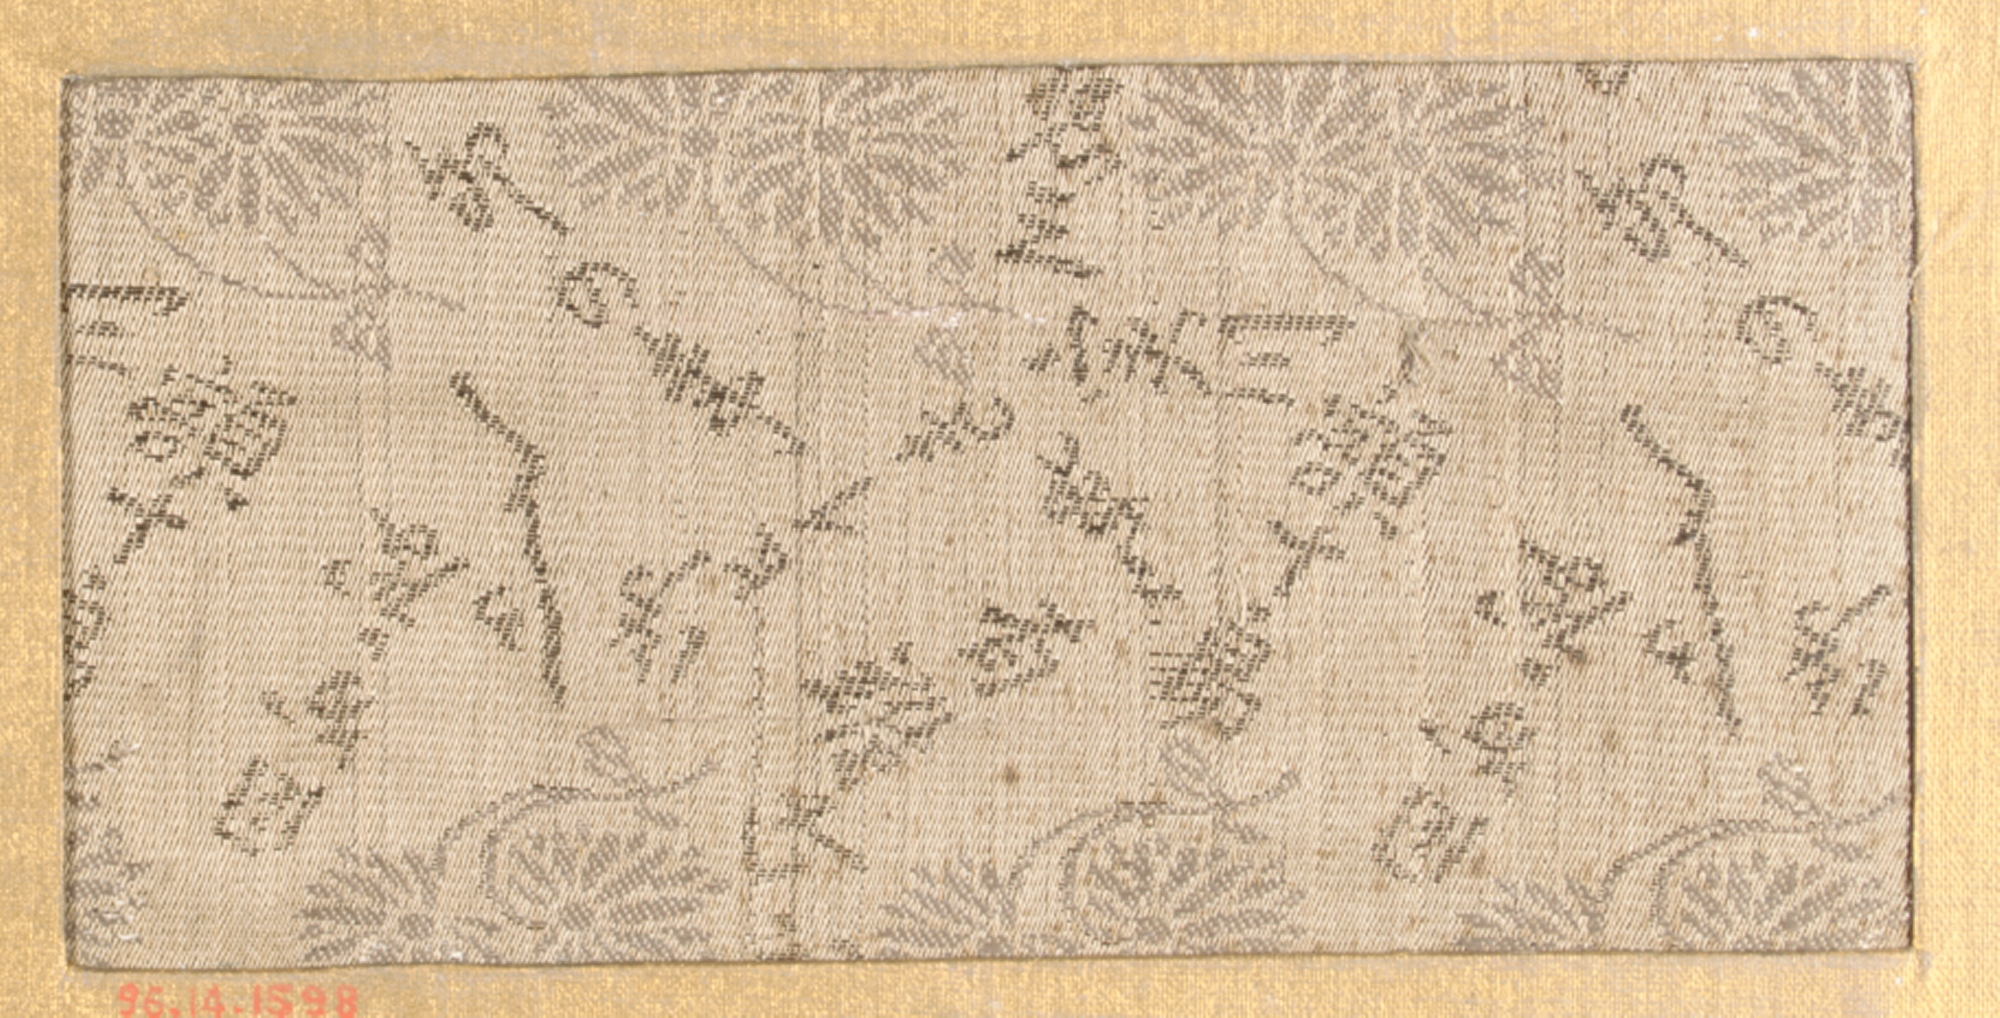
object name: piece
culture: japanese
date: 1701-1900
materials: silk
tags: flowers